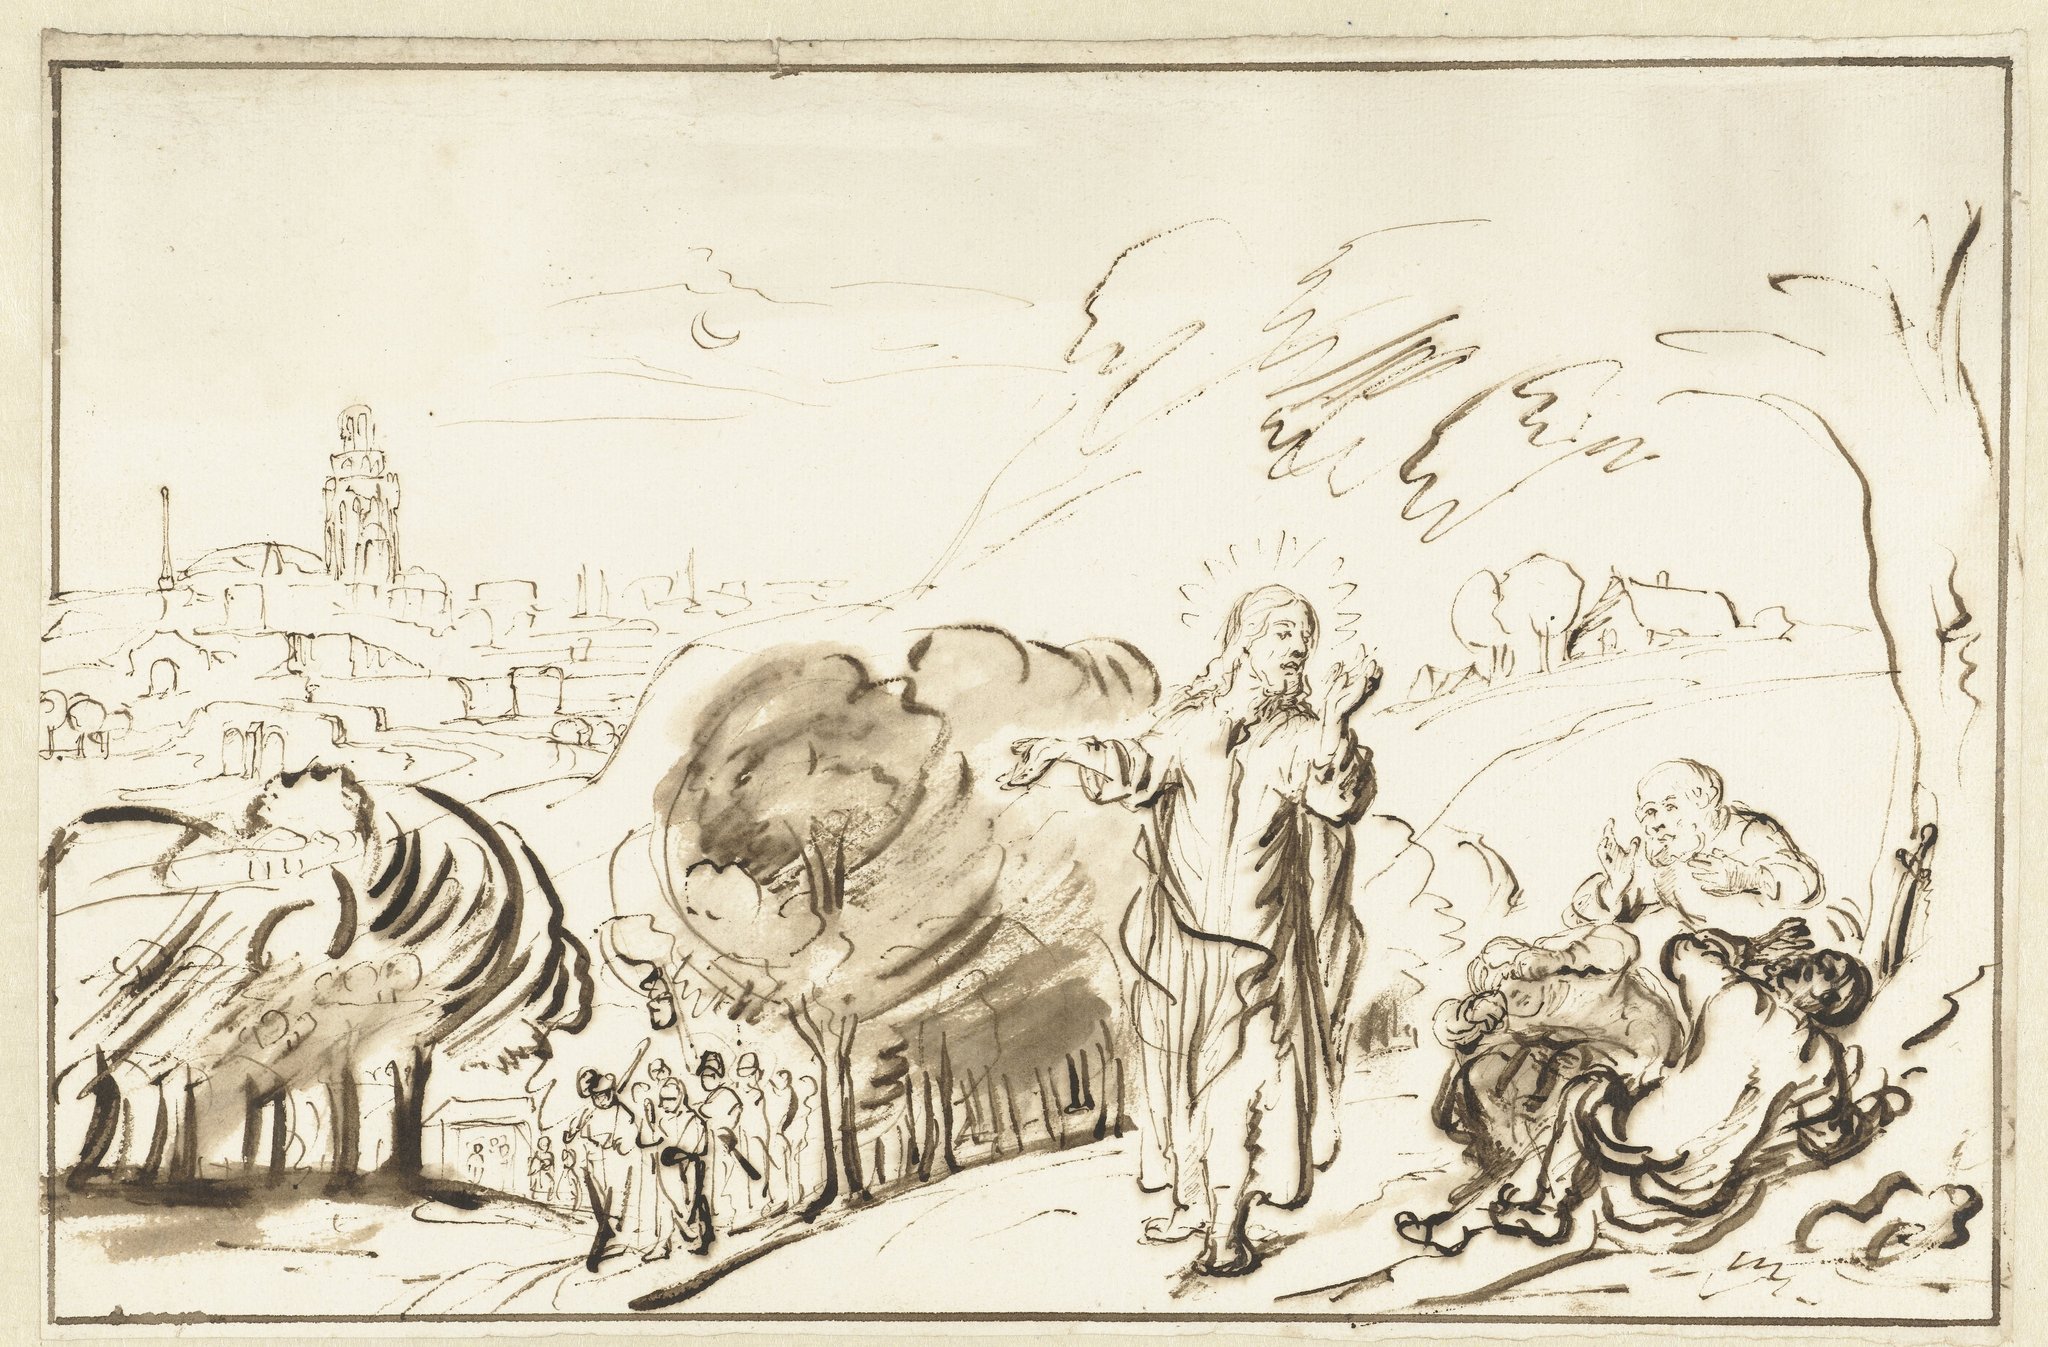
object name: drawing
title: Christus wekt de discipelen op de Olijfberg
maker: nicolaes maes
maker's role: draughtsman, painter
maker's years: 1634-1693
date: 1650-1660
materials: ink, paper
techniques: brush, pen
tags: christ summons the apostles to stay awake and pray ~ garden of gethsemane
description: Afkomstig uit een album met losliggende tekeningen van met name Matthijs Balen.